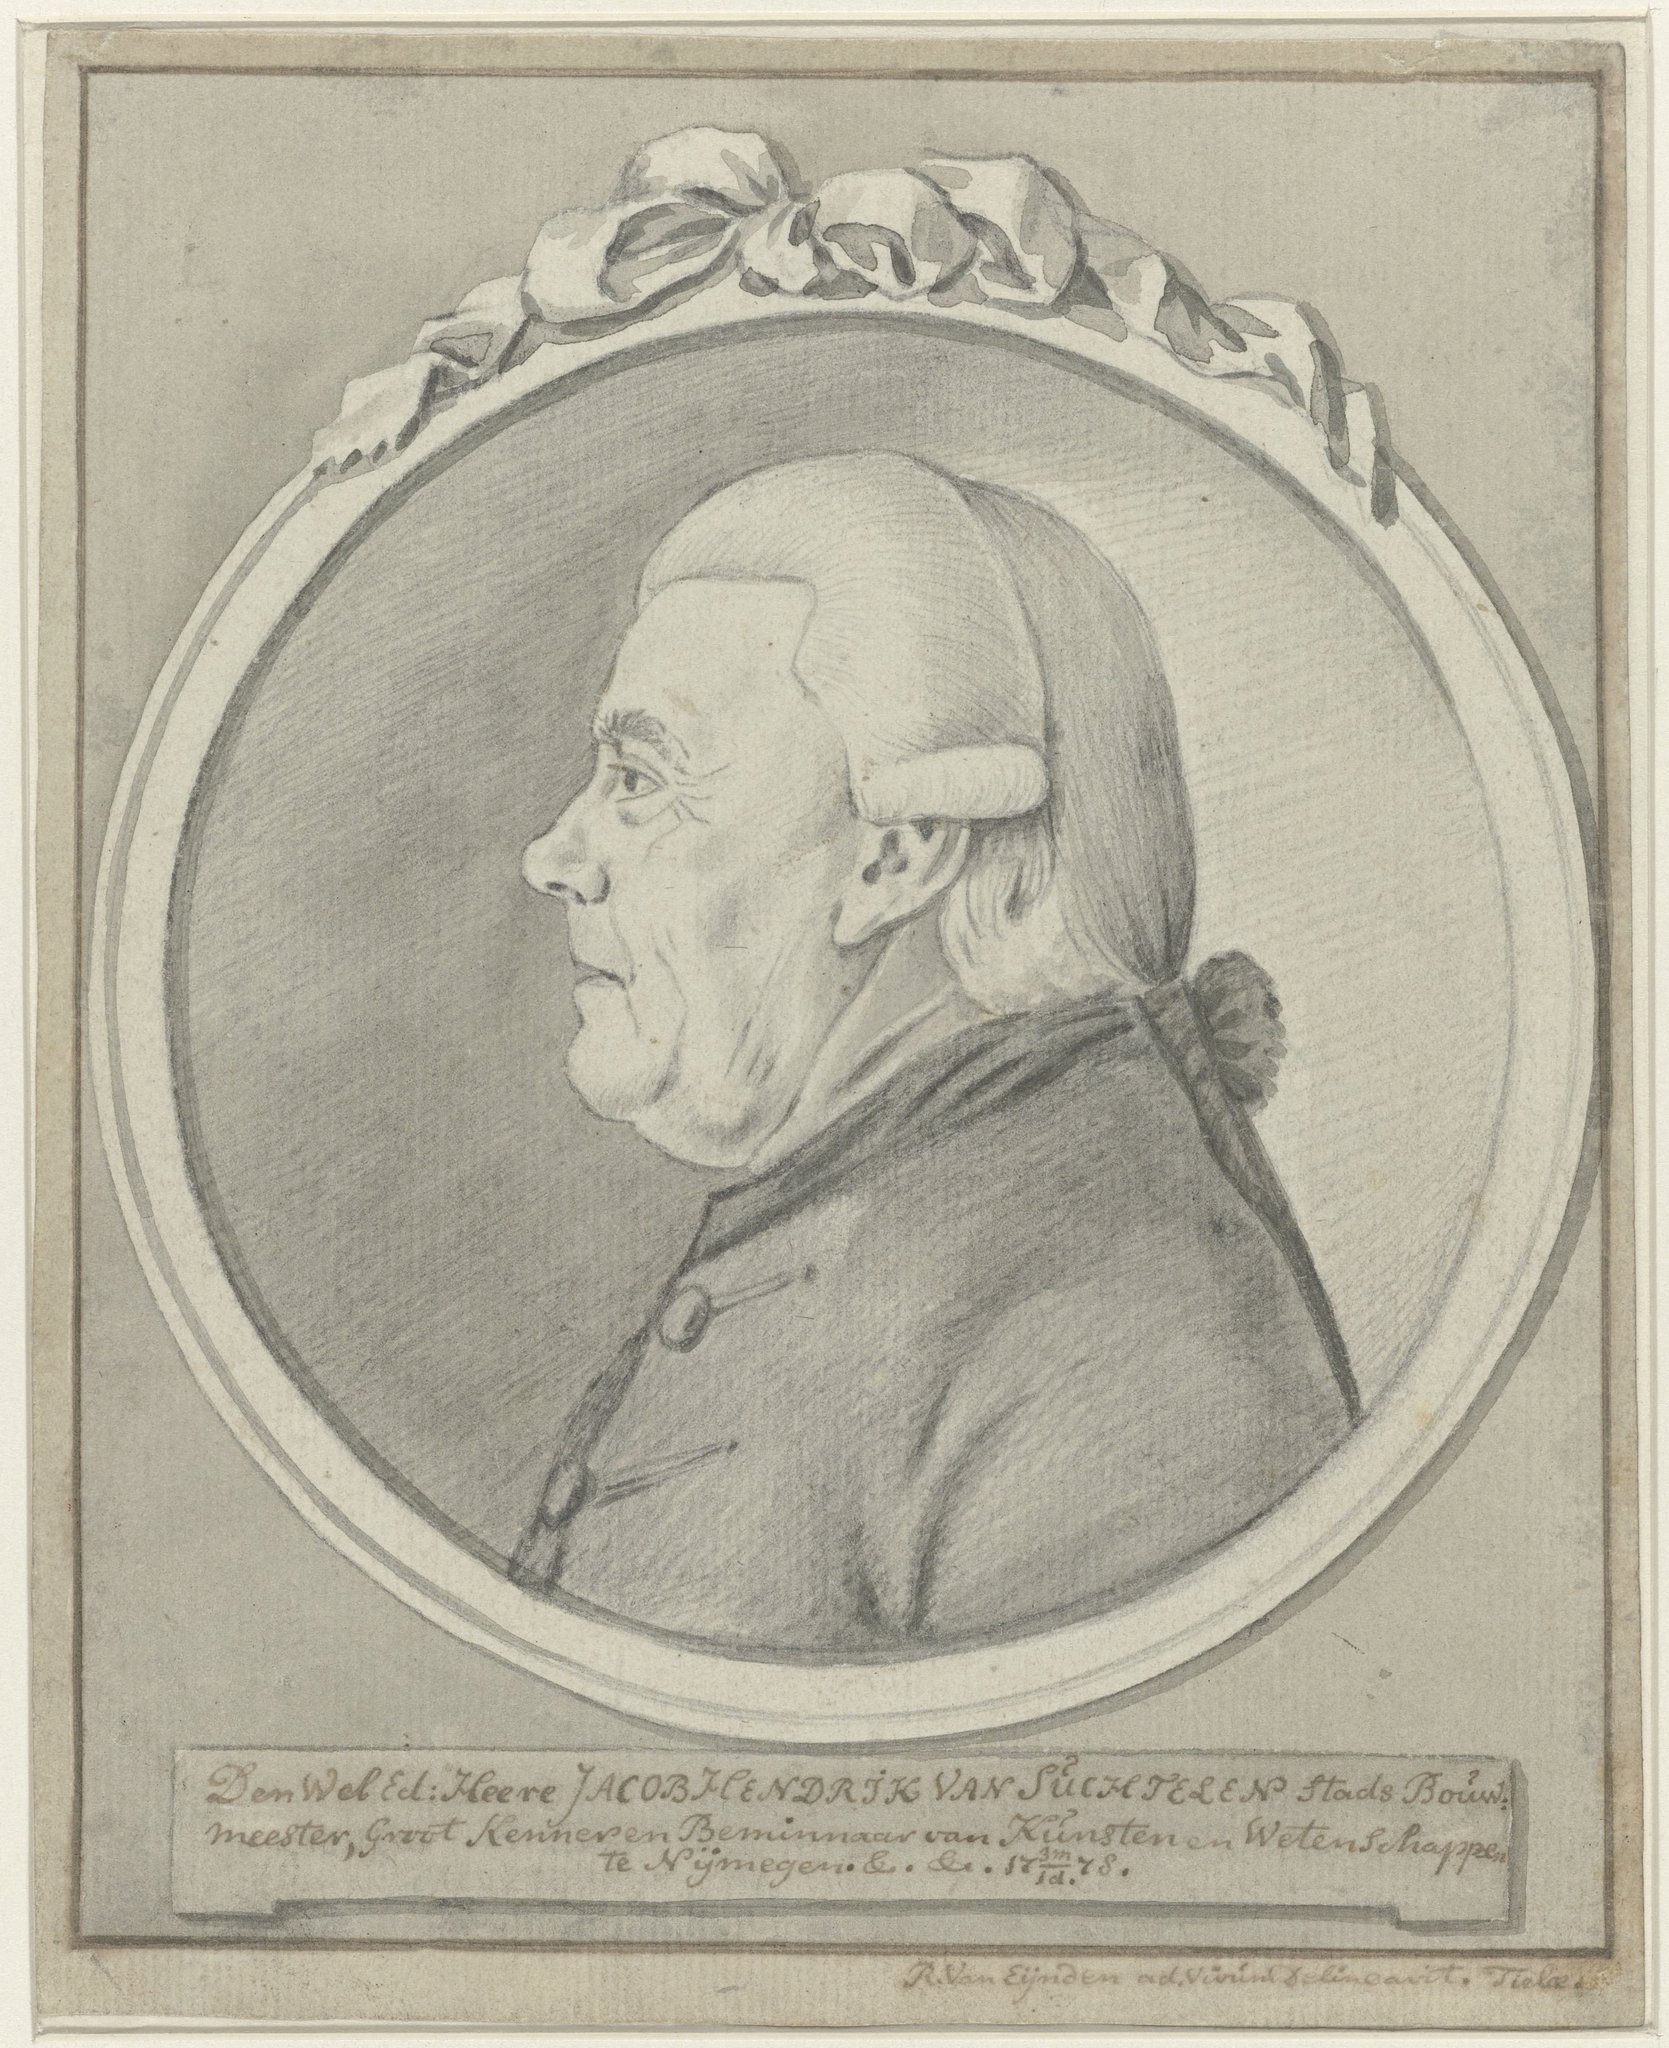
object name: drawing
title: Portret van de schilder Jacob Hendrik van Suchtelen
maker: roeland van eynden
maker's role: draughtsman, print maker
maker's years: 1747-1819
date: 1778-1819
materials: ink, paper, pencil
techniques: brush, pen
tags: nijmegen, jacob hendrik van suchtelen, historical persons, portrait, self-portrait of painter, portrait, self-portrait of artist